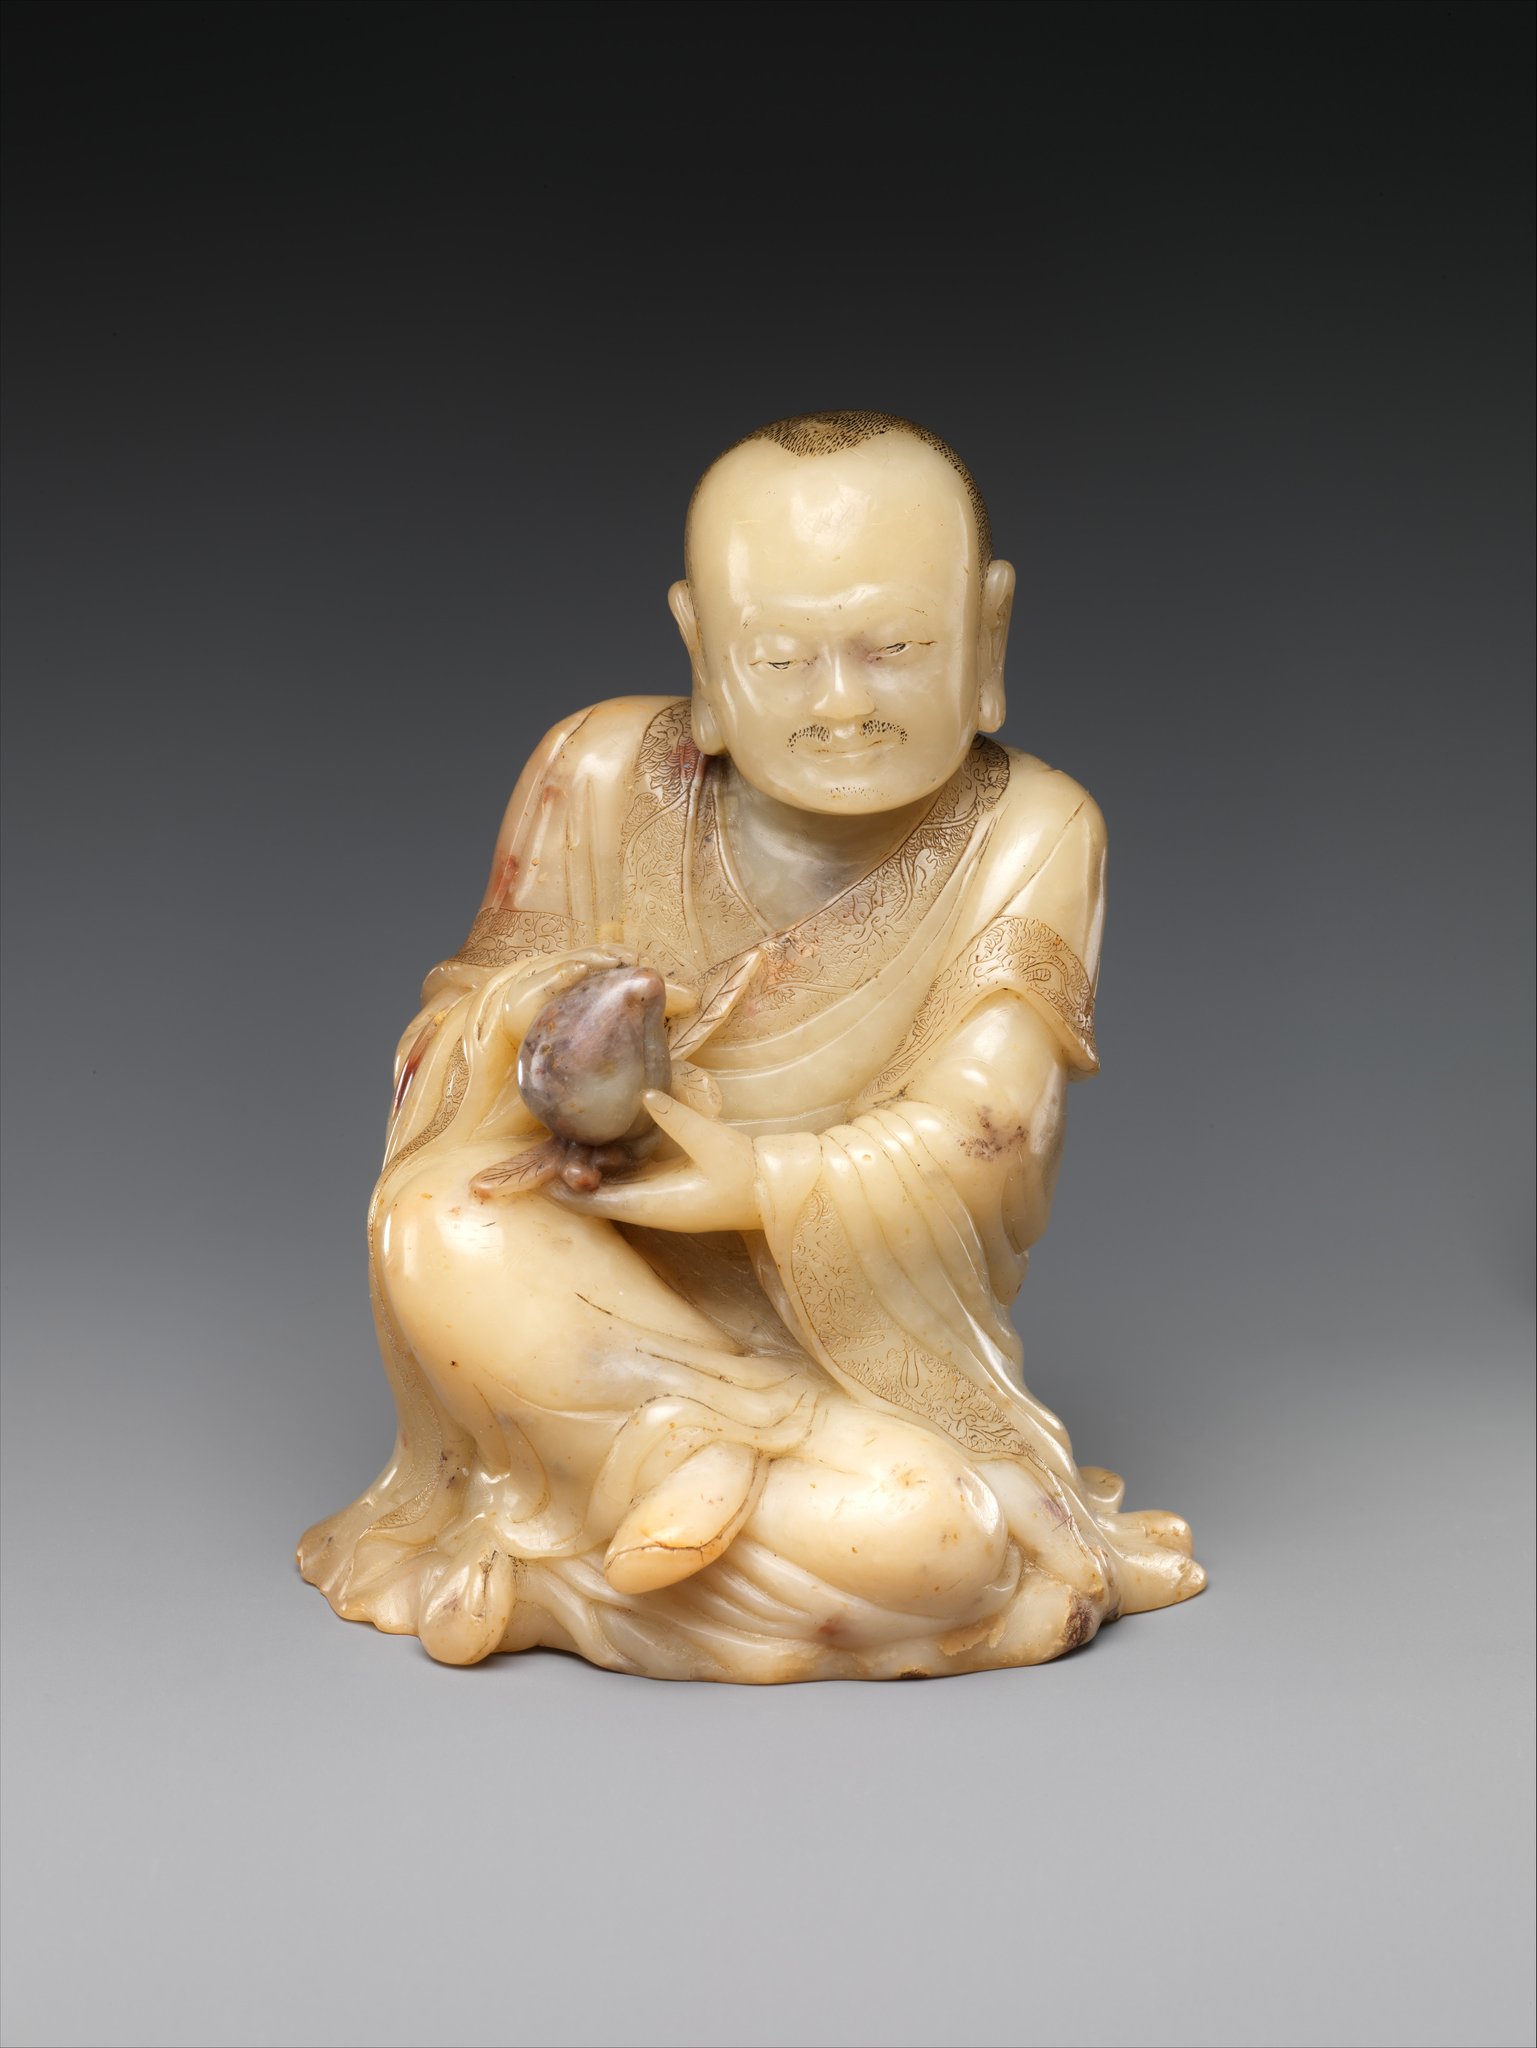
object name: figure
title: Buddhist disciple, or luohan, holding a peach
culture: chinese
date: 1601-1700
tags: peaches,men,buddhism